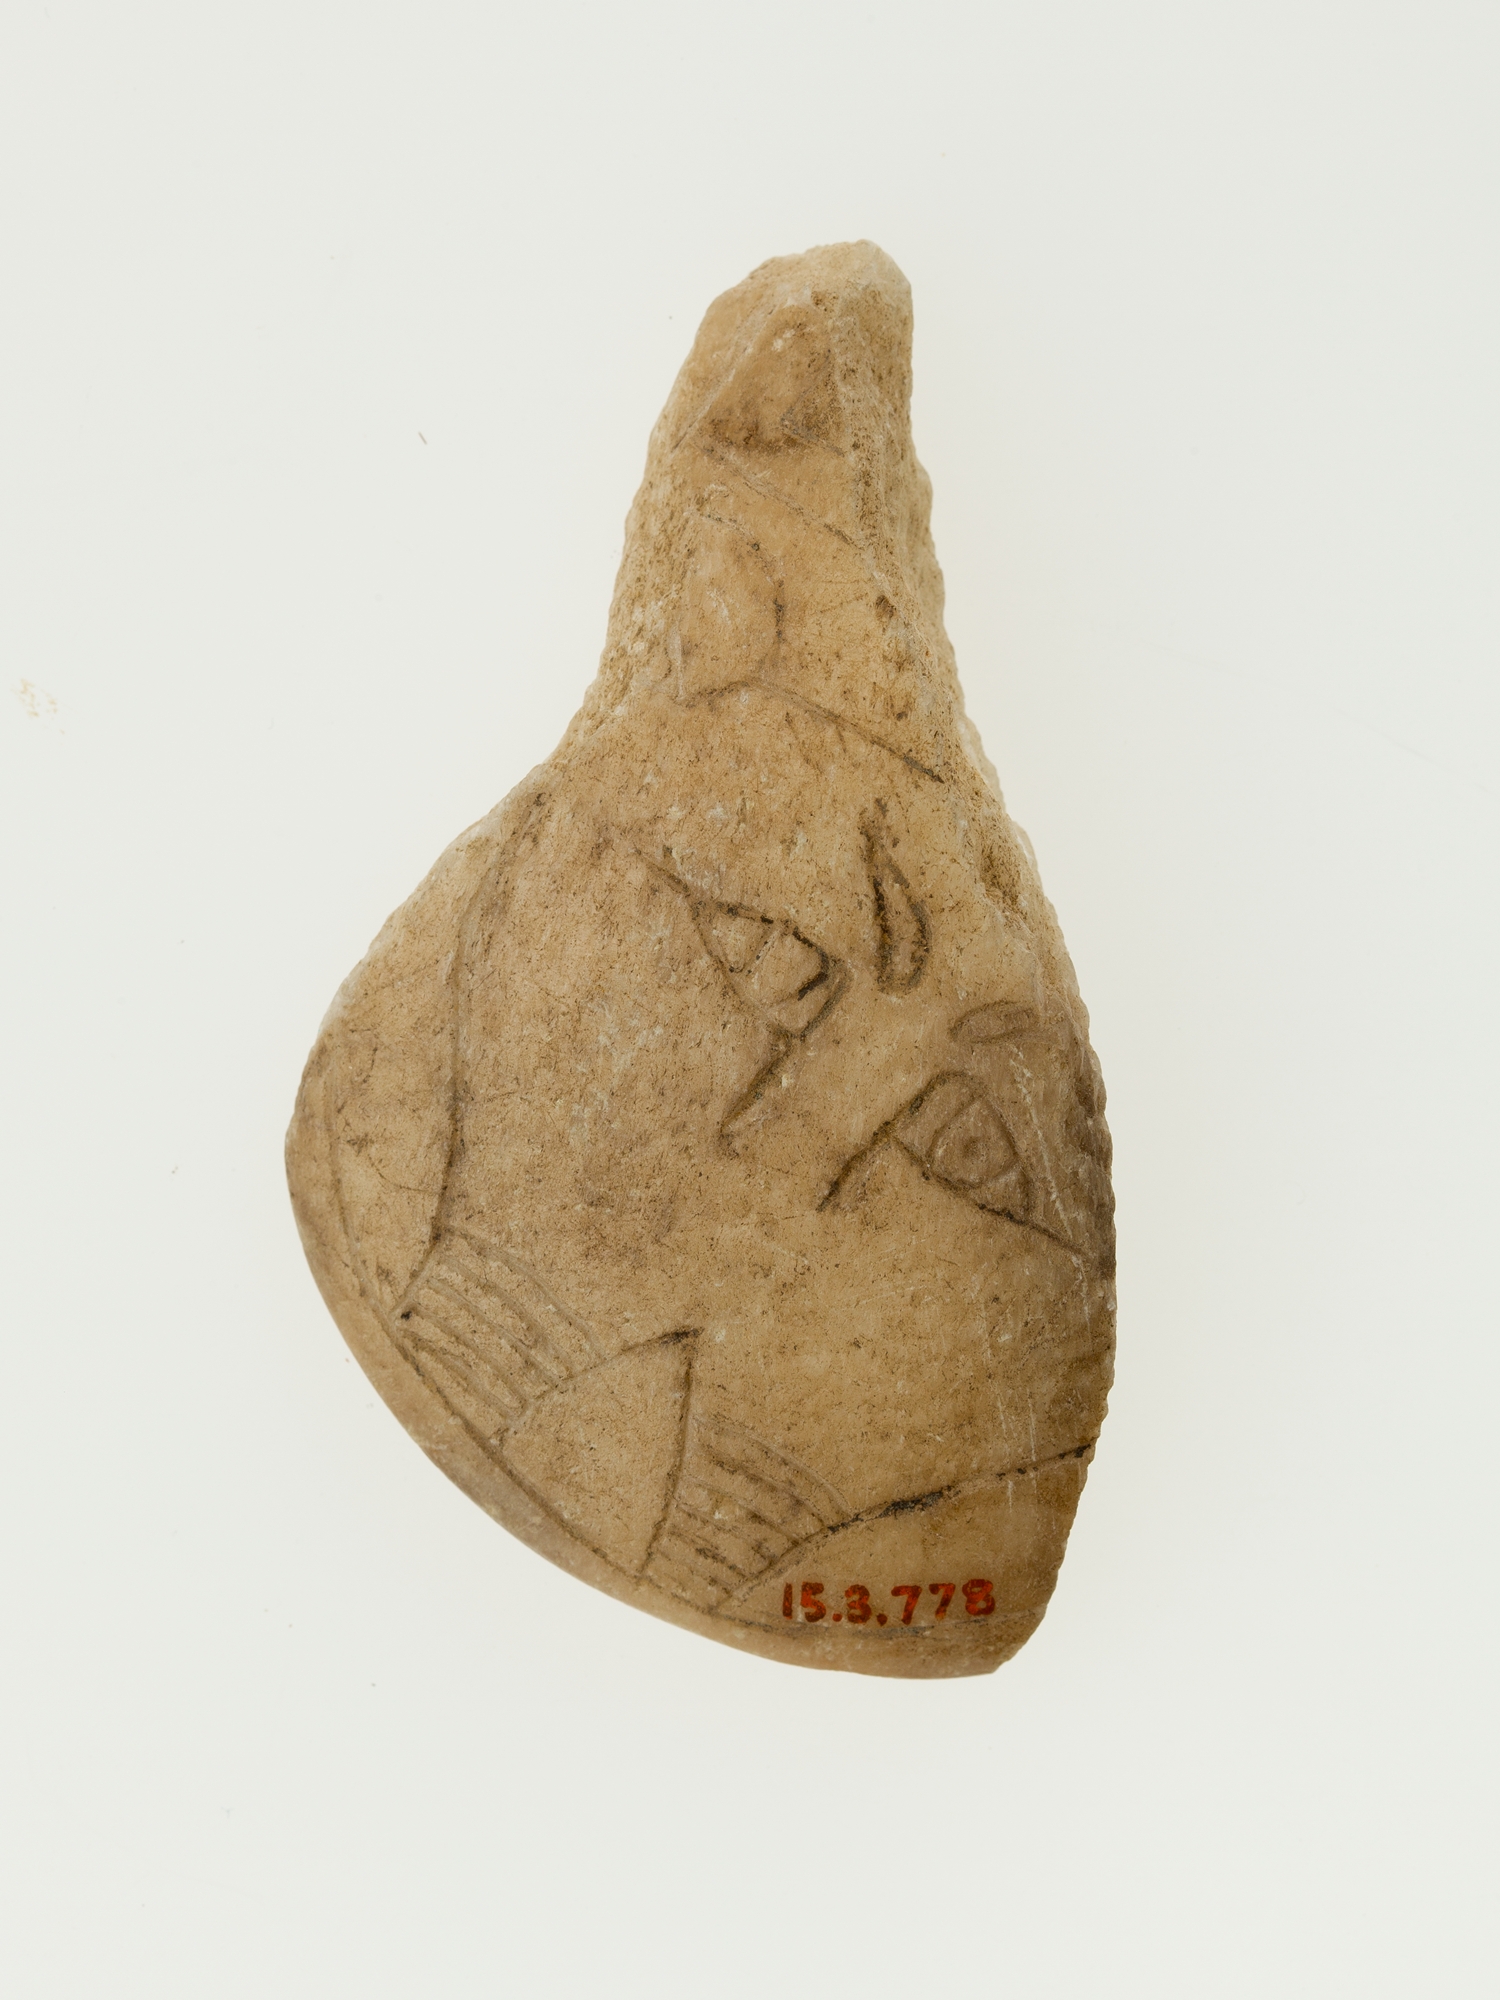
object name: magic knife fragment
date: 1981-1640 BCE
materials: stone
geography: egypt